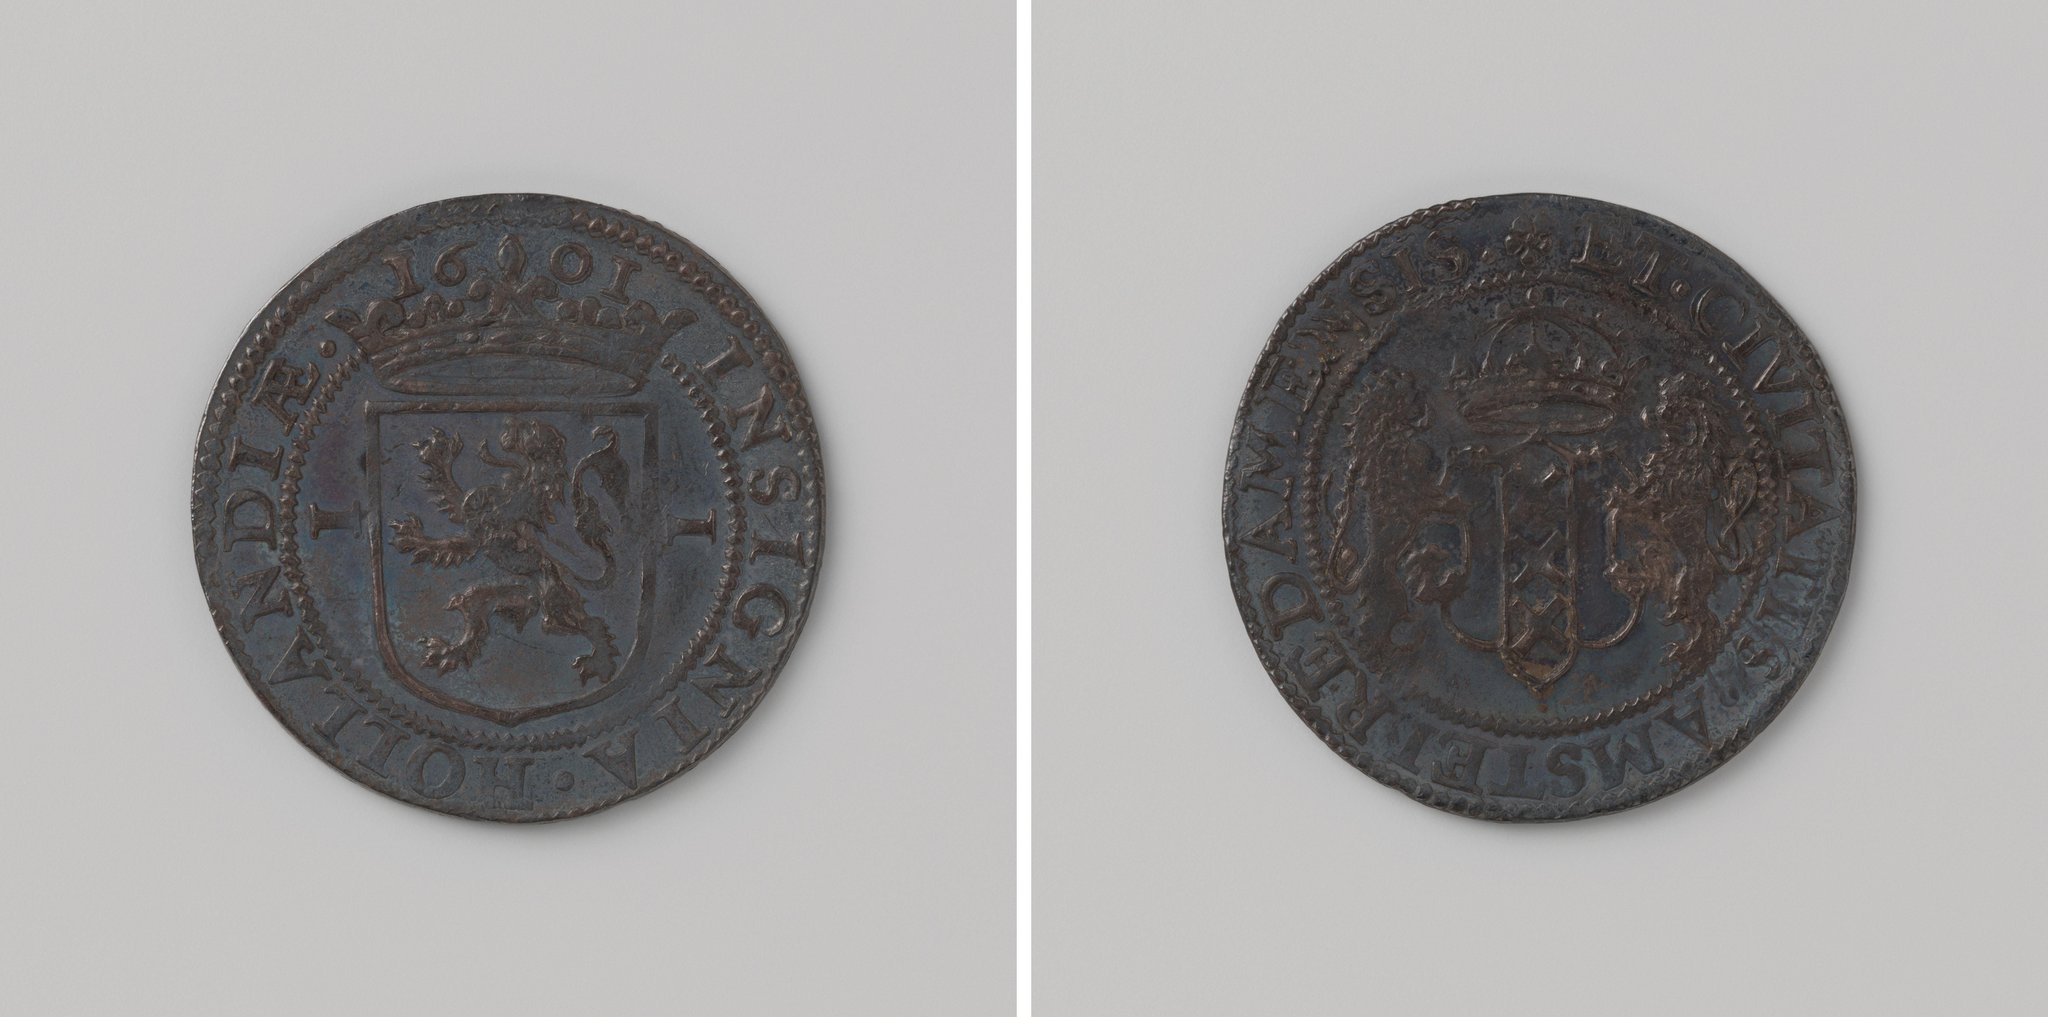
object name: dubbele reaal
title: Verenigde Amsterdamse Compagnie, zilveren munt ter vervanging van de Spaanse dubbele reaal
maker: jacob de jonge (muntmeester)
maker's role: mintmaster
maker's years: 1580-1607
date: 1601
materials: silver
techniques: striking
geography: dordrecht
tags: dordrecht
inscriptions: inscription: ‘ET CIVITATIS AMSTELREDAMENSIS’, inscription: ‘INSIGNIA HOLLANDIAE’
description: Munt ter vervanging van de Spaanse 2 reaal. Door gebrek aan voldoende gemunt metaal in de vorm van Spaanse realen kreeg de compagnie in 1600 van de Staten van Holland om vervangende munten te laten slaan. Op voorwaarde dat de munten niet in de Nederlanden in omloop werden gebracht.